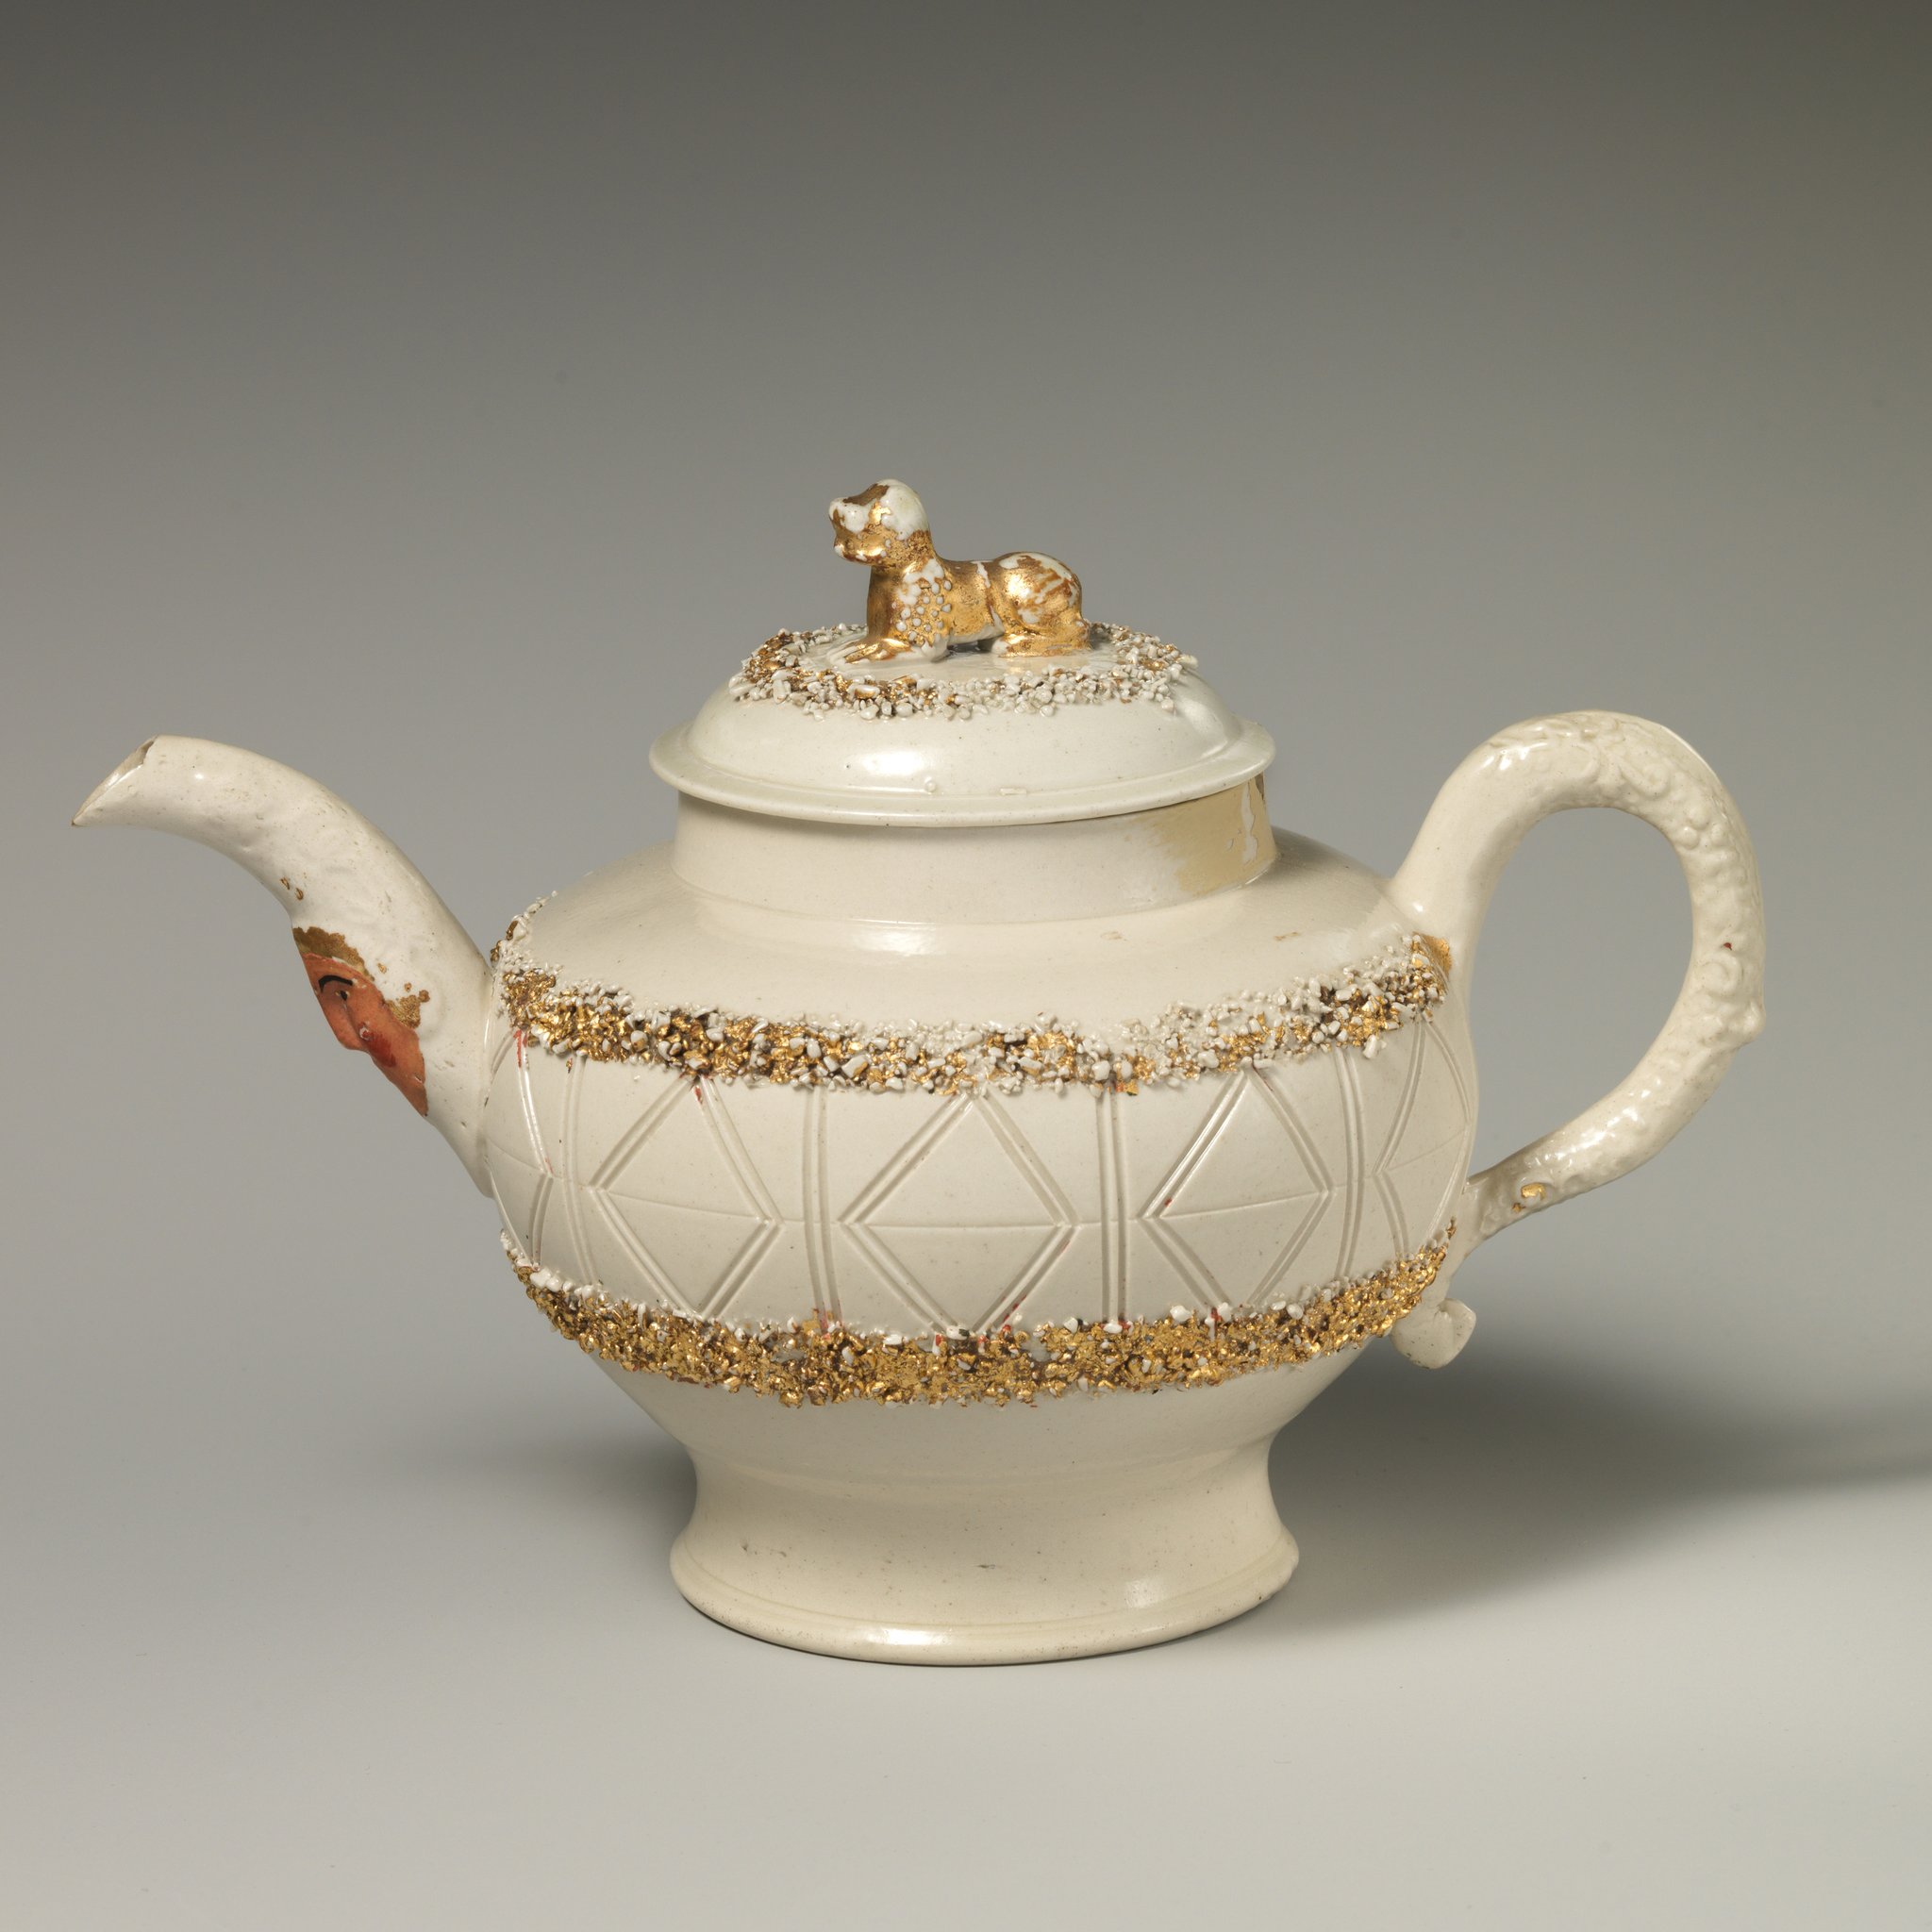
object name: teapot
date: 1740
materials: stoneware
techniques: salt glaze